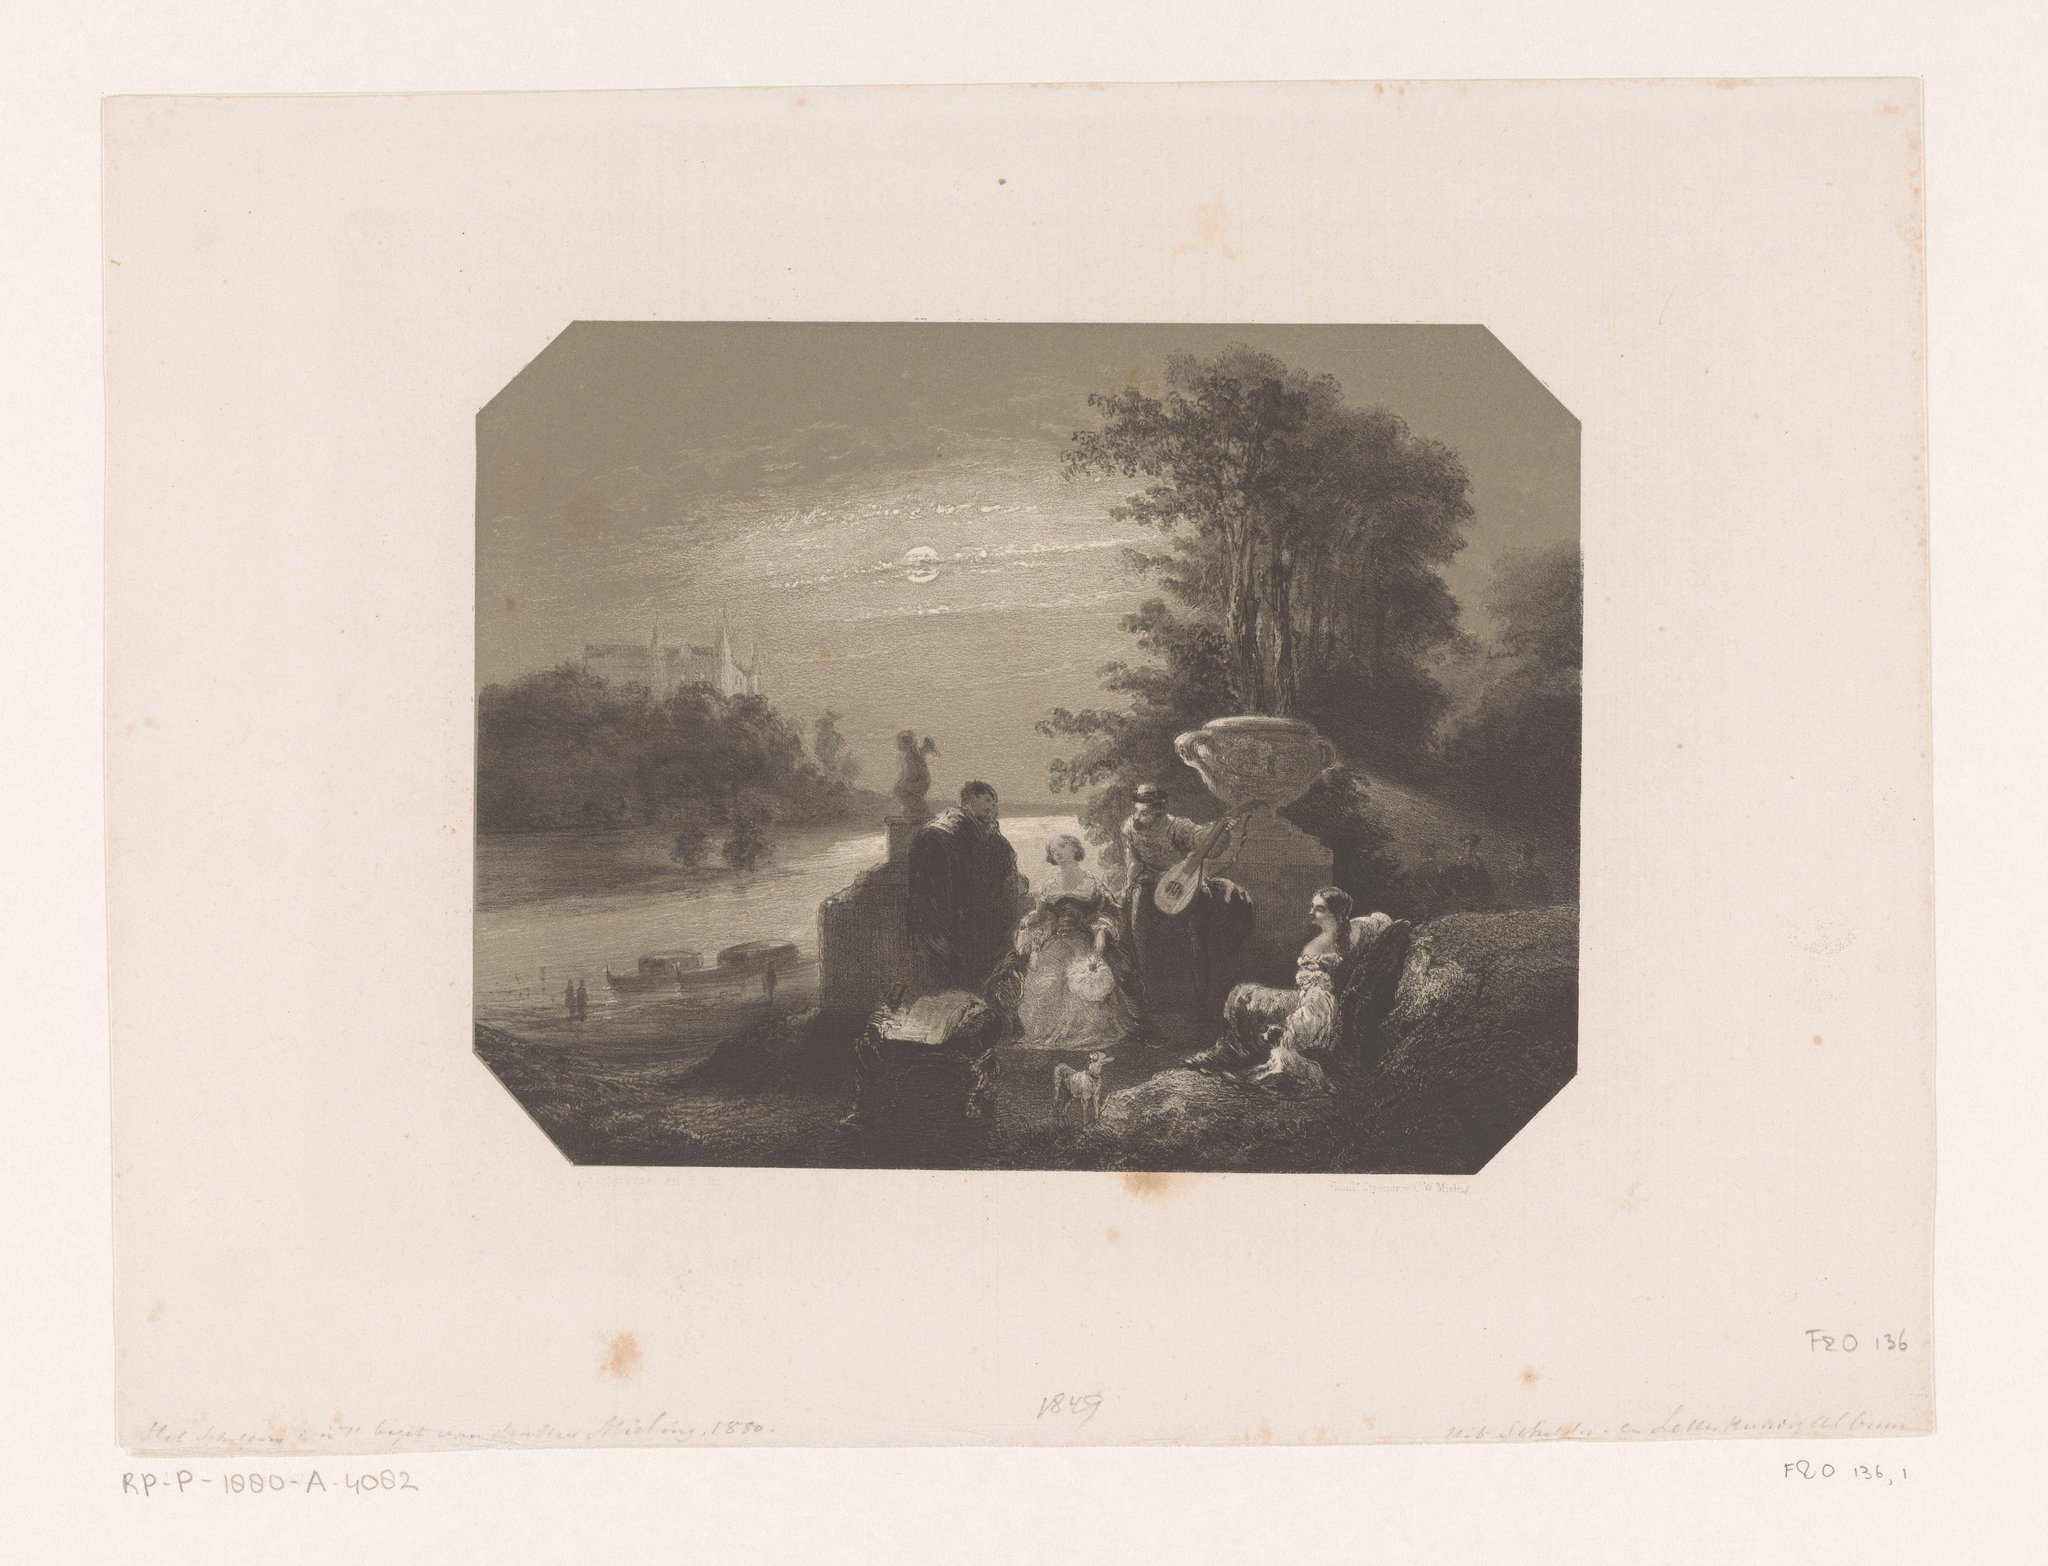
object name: book illustration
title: Mannen en vrouwen in landschap bij maanlicht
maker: charles rochussen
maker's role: draughtsman, painter, print maker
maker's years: 1814-1894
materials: paper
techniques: tone lithography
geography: the hague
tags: moonlight, landscapes (+ landscape with figures, staffage)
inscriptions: collector's mark: Lugt 2228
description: Twee mannen en vrouwen in Italiaanse kleding in een landschap bij maanlicht. De man rechts houdt een luit in zijn hand. In de achtergrond boten op water en een kasteel. Behoort bij het gedicht Italien door Samuel Johannes van den Bergh.